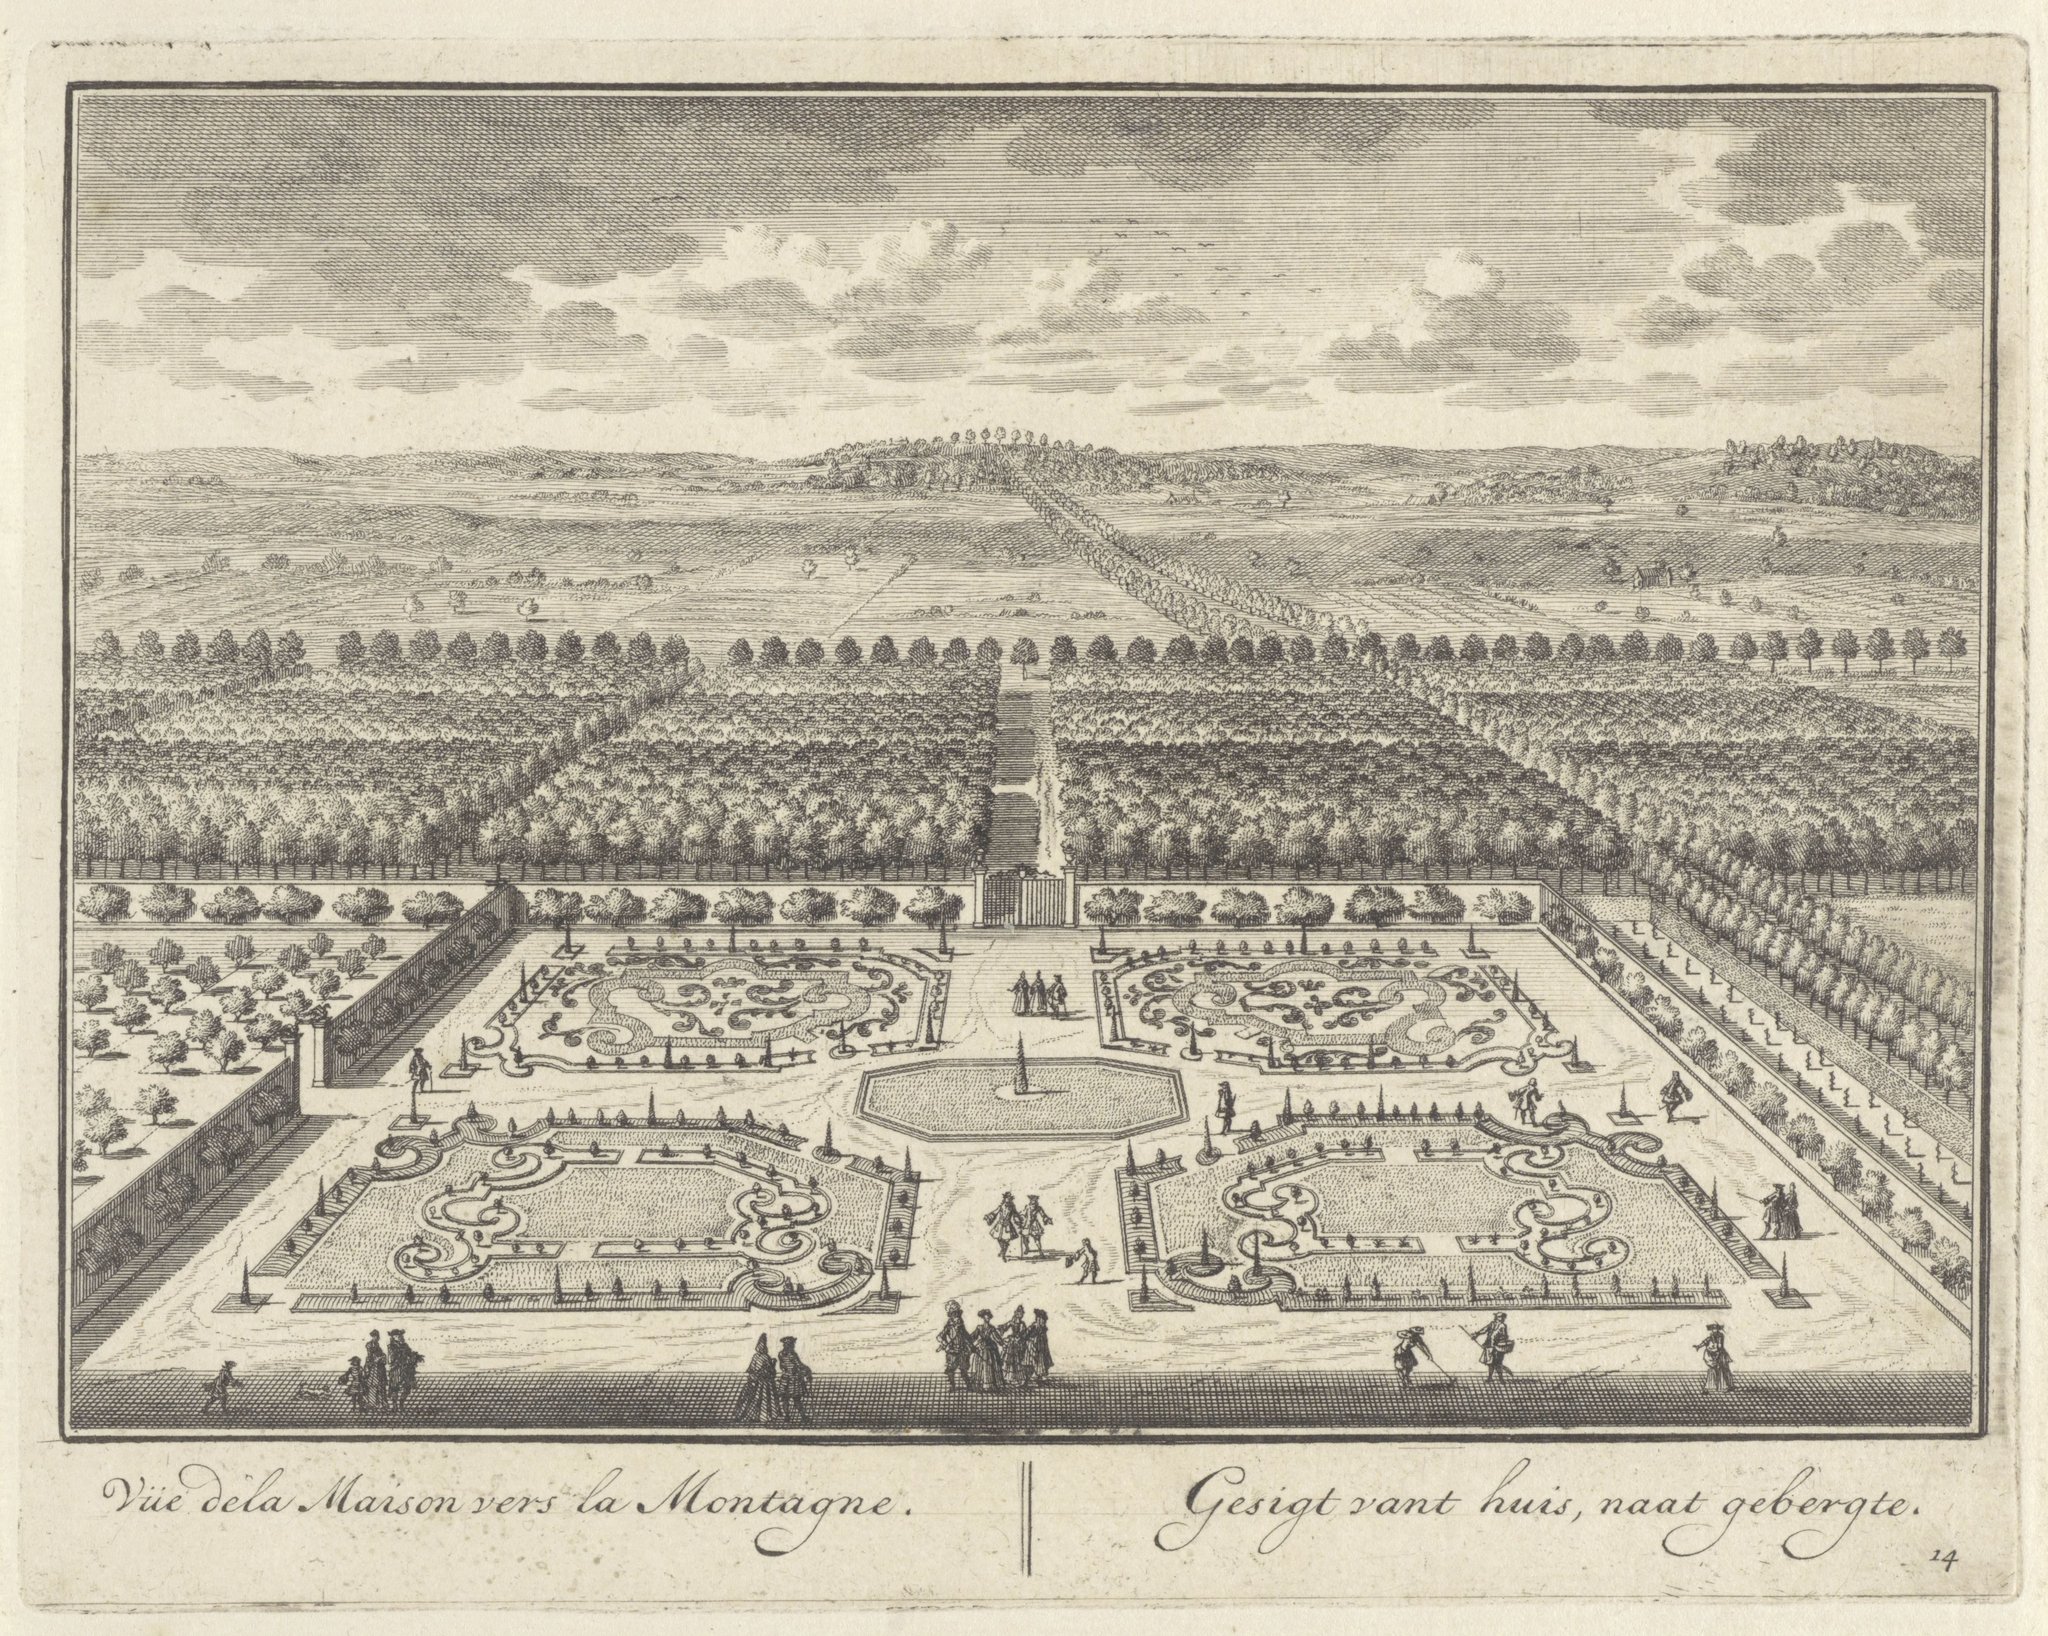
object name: print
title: Gezichten op kasteel Zuilenstein te Leersum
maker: daniël stopendaal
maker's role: print maker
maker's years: 1672-1726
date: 1682-1726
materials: paper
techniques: etching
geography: amsterdam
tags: french or architectonic garden; formal garden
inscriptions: collector's mark: Lugt 2228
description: Gezicht vanuit Kasteel Zuilenstein te Leersum op de tuinen en de omgeving in de richting van de Utrechtse Heuvelrug.